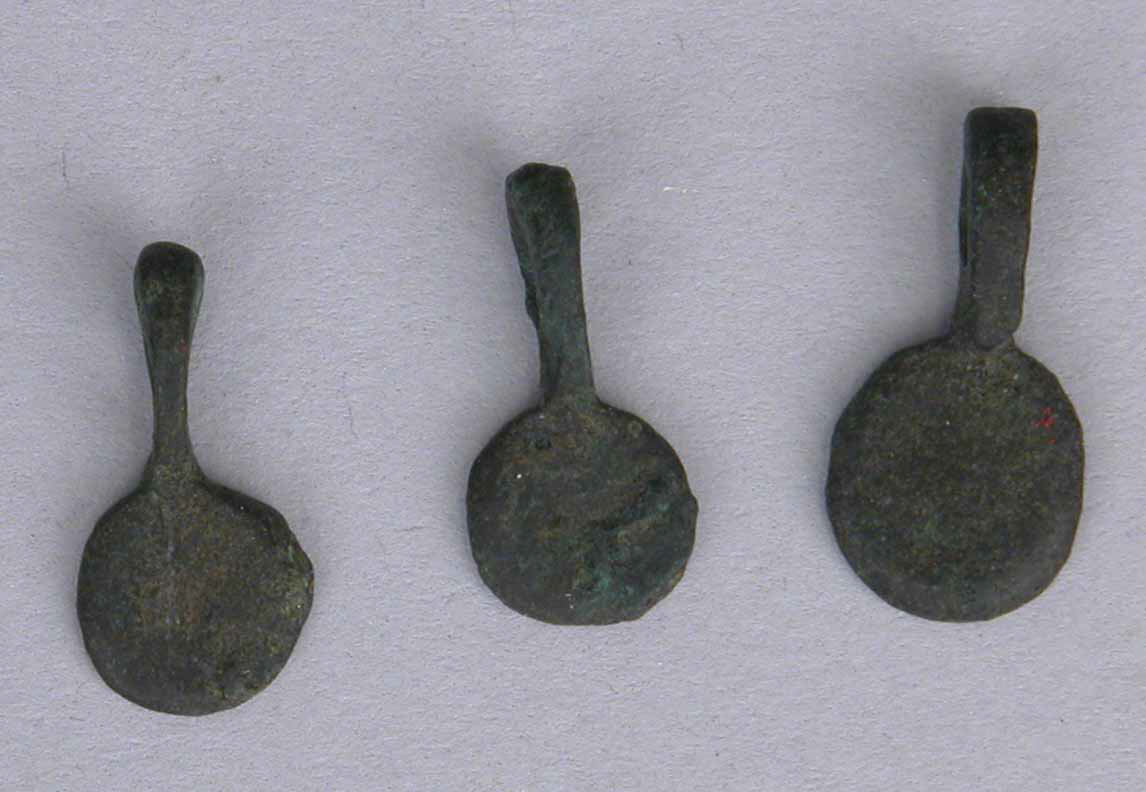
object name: pendant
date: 801-1200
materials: bronze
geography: egypt